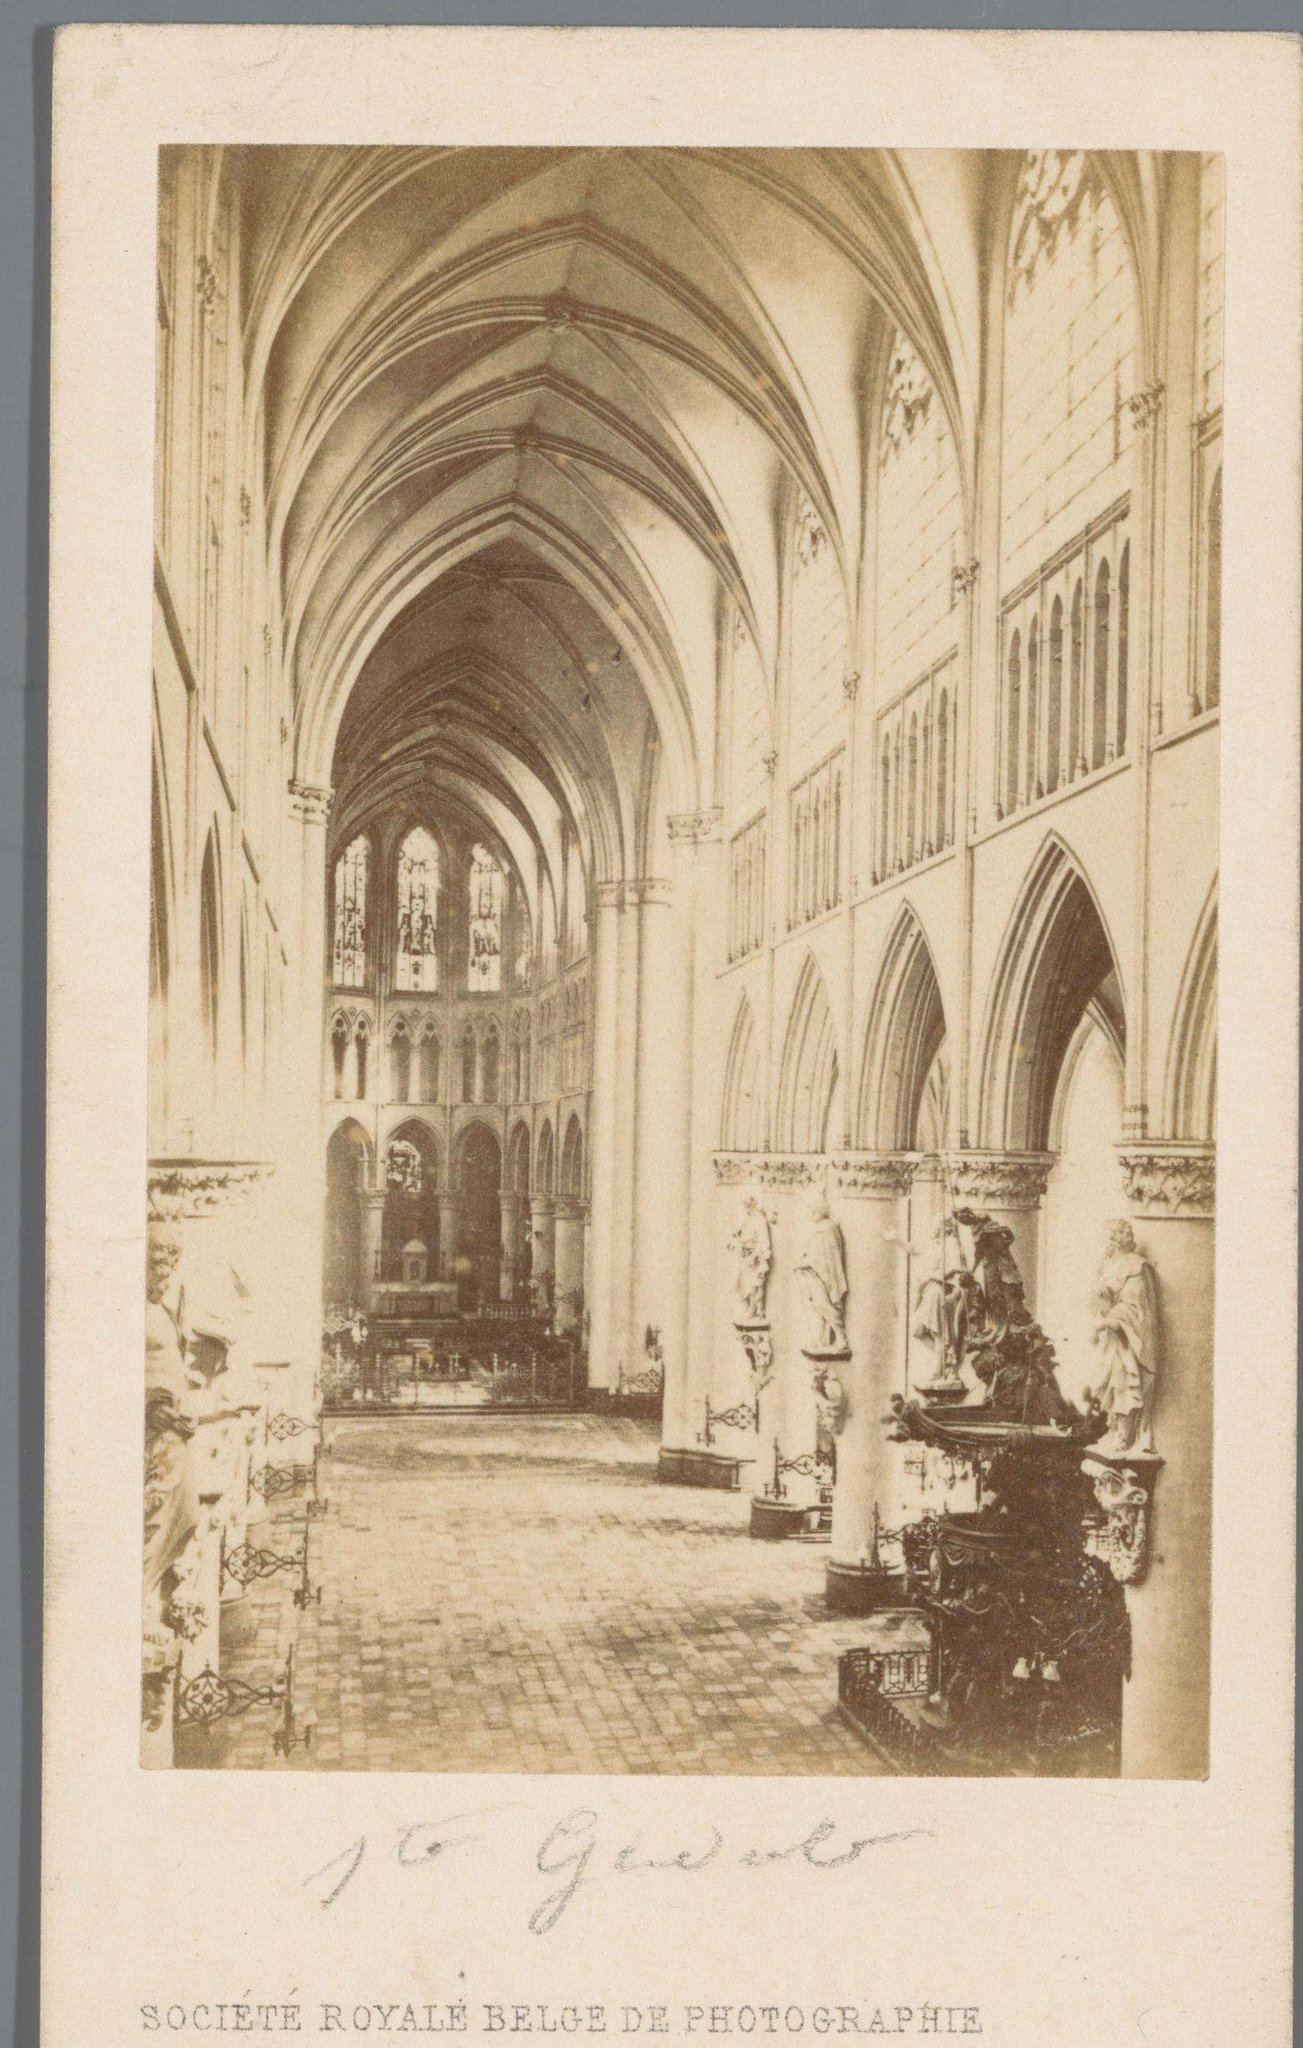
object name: carte de visite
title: Ste Gudule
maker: Anonymous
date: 1862-1893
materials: cardboard, paper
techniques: albumen print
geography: brussels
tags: interior of church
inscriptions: inscription: ‘Société Royale Belge/ de Photographie/ 73. Rue Keyenveld, 73./ Ixelles/ Bruxelles’, inscription: ‘Société Royale Belge de Photographie’